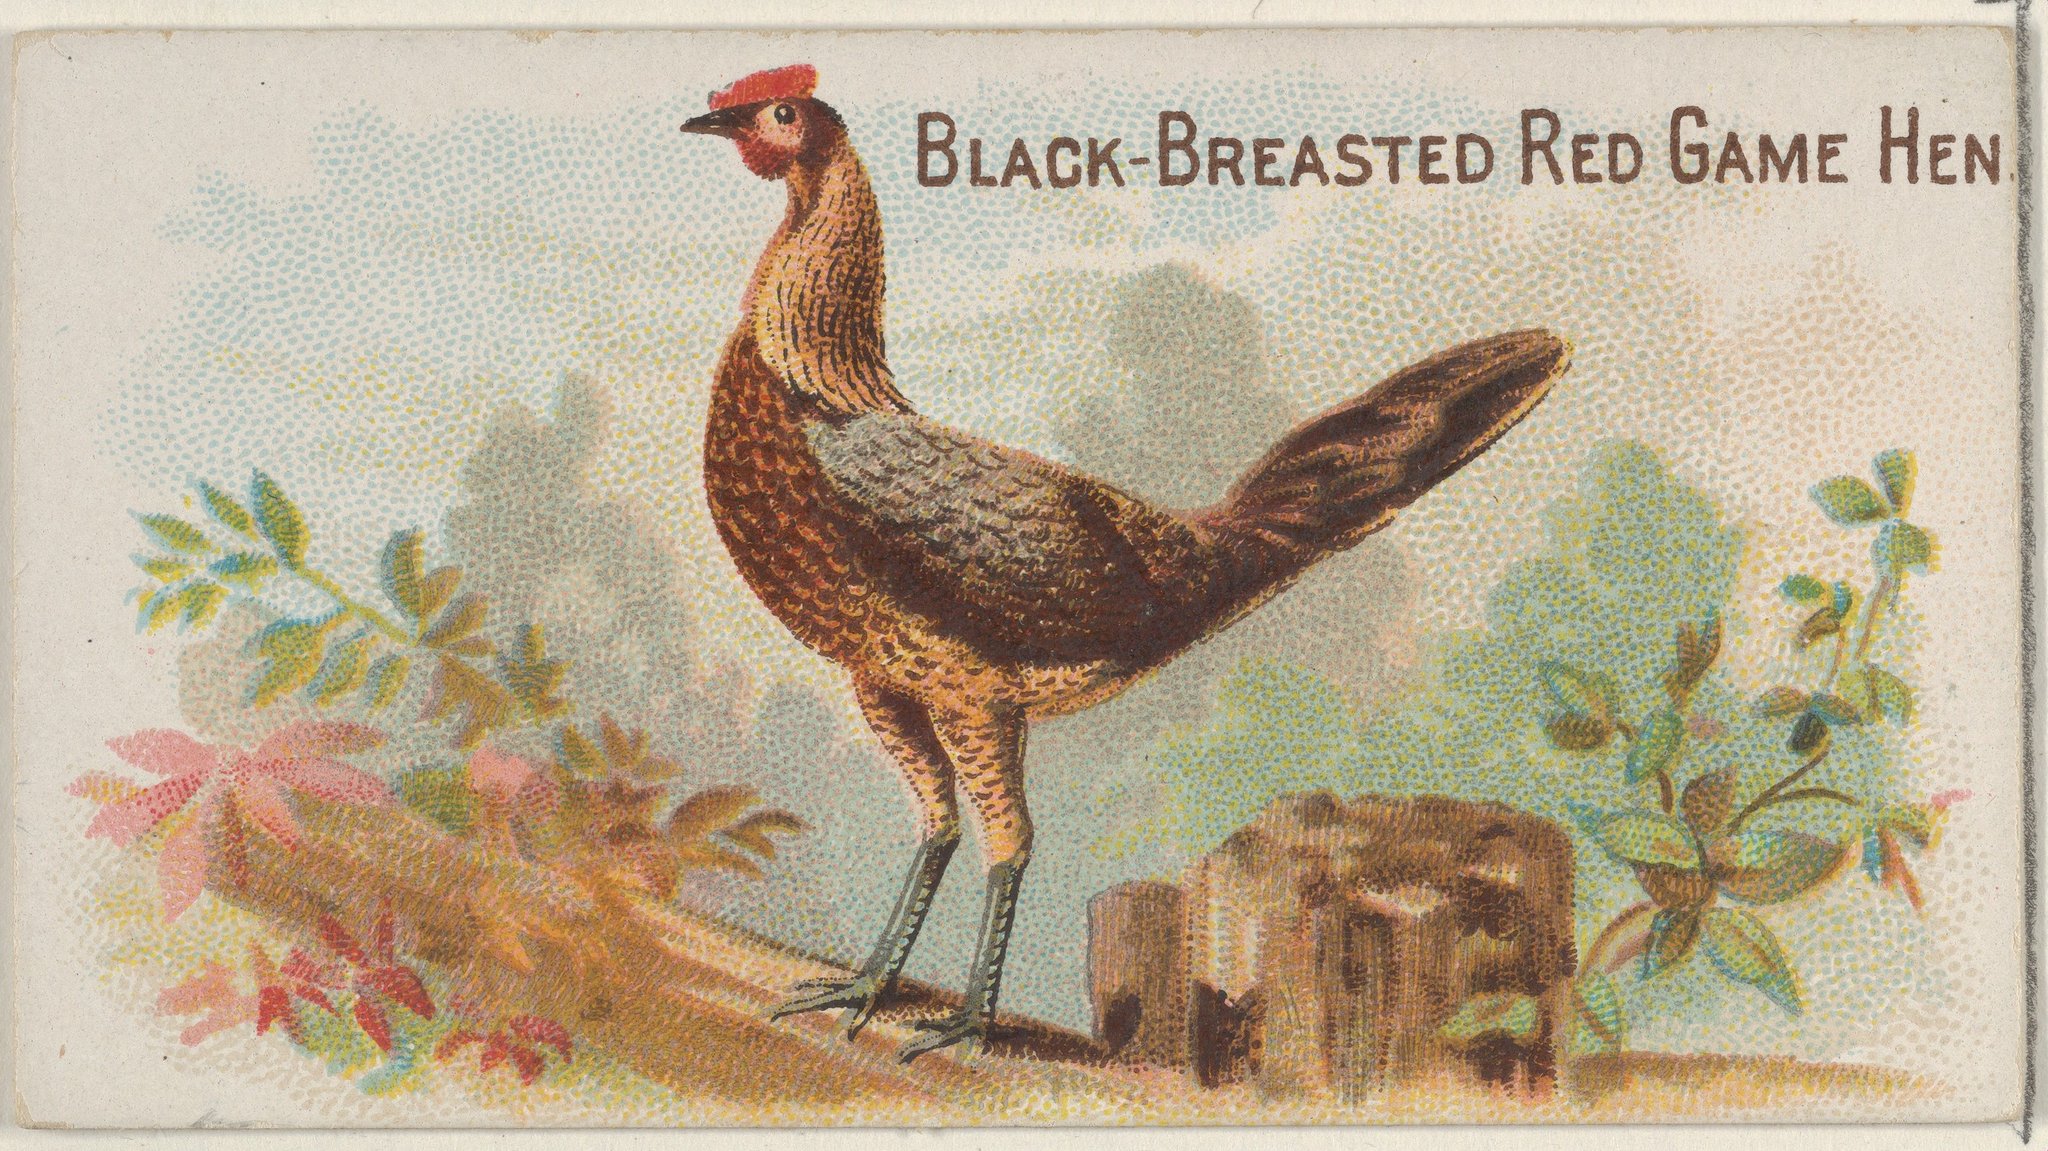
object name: print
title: Black-Breasted Red Game Hen, from the Prize and Game Chickens series (N20) for Allen & Ginter Cigarettes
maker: allen & ginter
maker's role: publisher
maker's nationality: american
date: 1891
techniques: color lithograph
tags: chickens